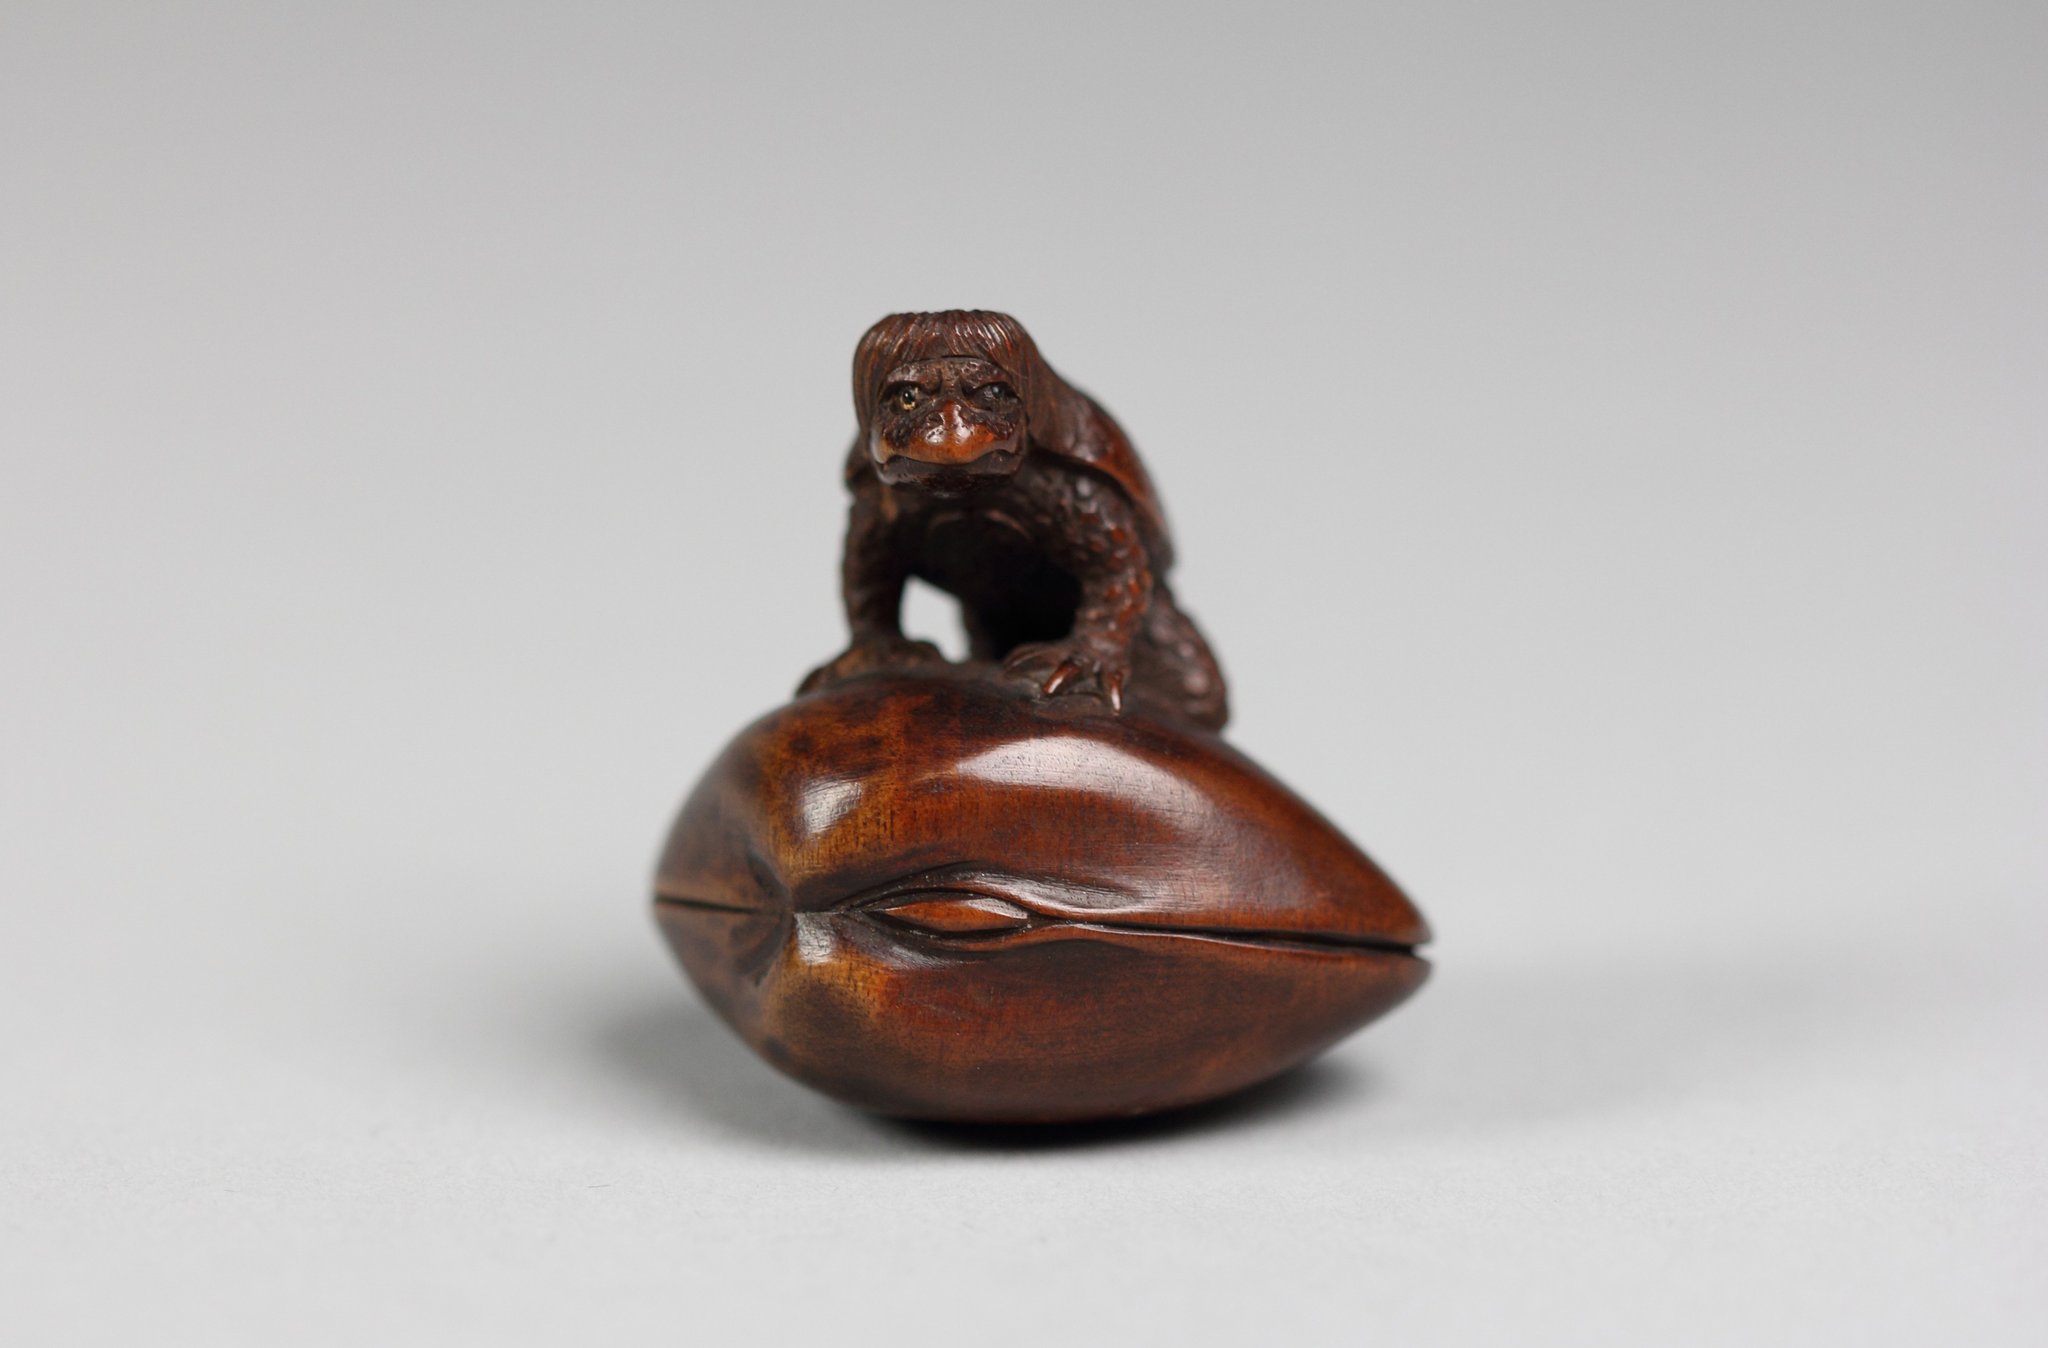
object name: netsuke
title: Netsuke of a Kappa on a Clamshell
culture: japanese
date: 1801-1900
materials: wood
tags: animals,shells